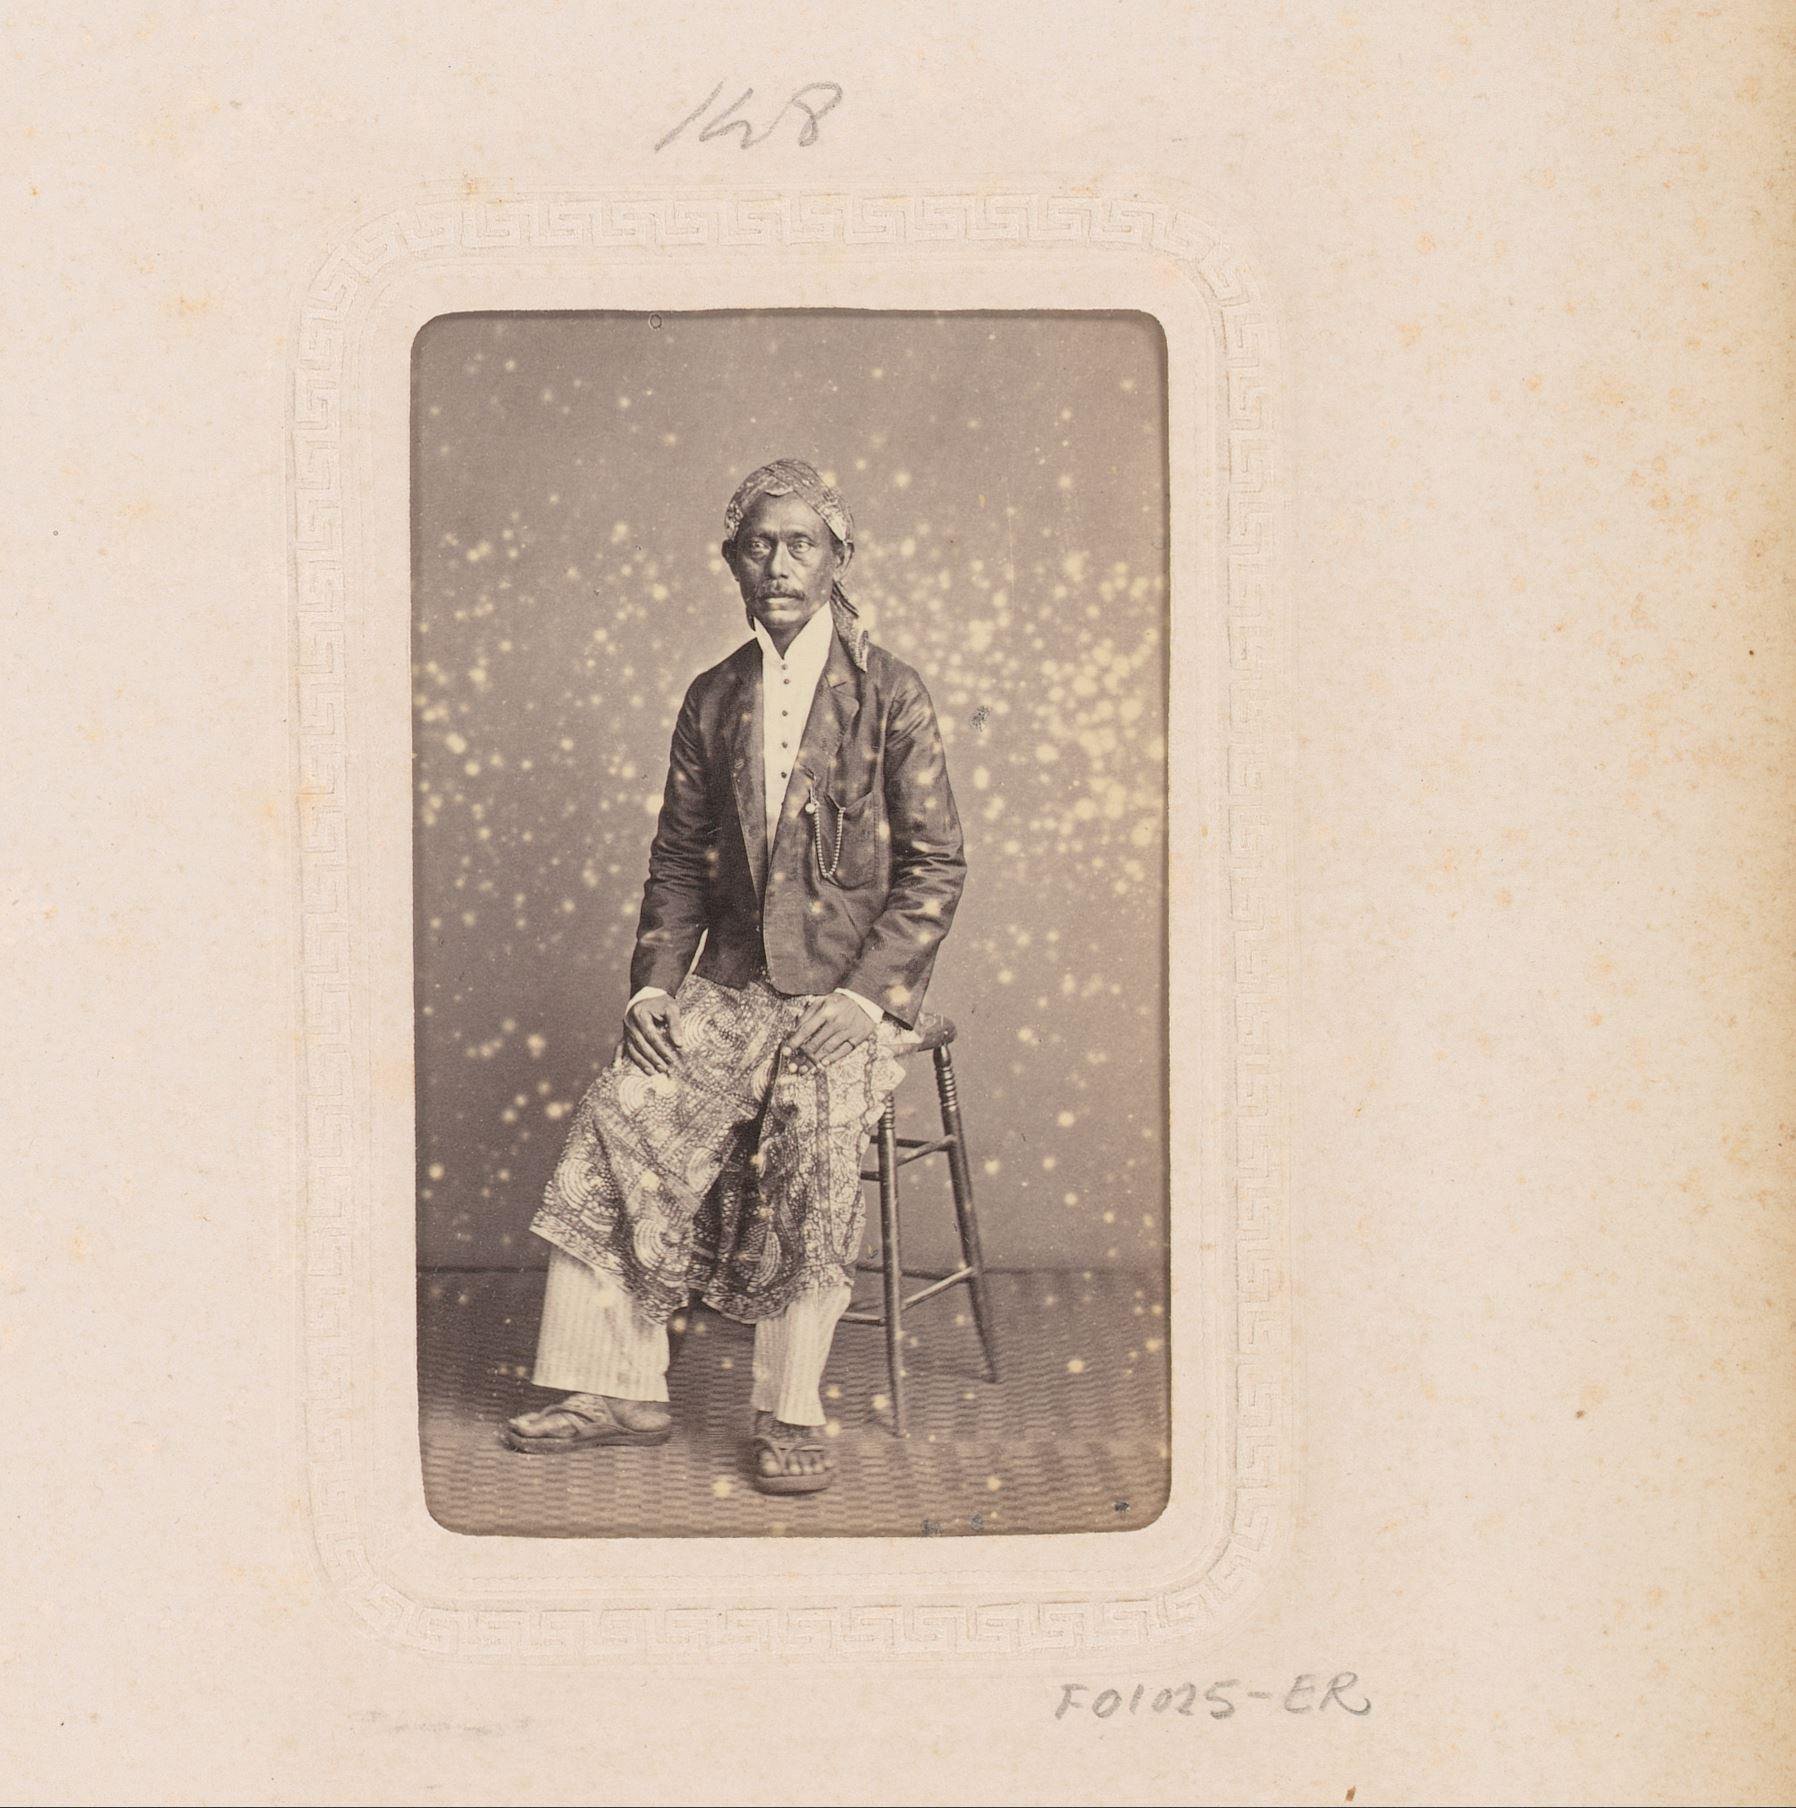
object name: album leaf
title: Portret van een Indonesische man op kruk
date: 1857-1880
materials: cardboard, photographic support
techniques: albumen print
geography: java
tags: historical persons, old man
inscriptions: number: ‘148’, inscription: ‘Woodbury & Page/ Photographers/ Java’